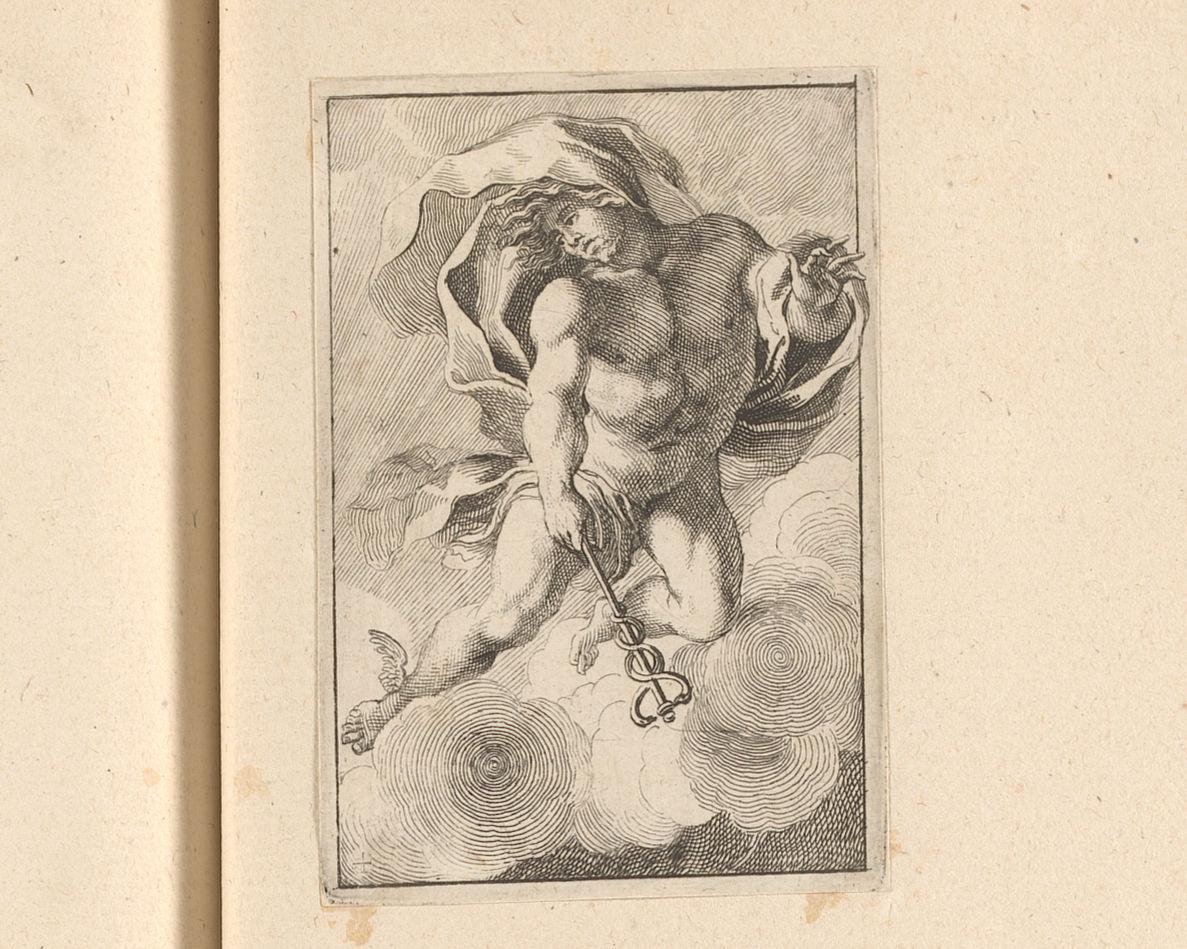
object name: album leaf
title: Mercurius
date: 1665-1673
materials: paper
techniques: etching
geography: paris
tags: model-books ~ implements of painter, (story of) mercury (hermes)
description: Maakt deel uit van een 32-delige serie met tekenvoorbeelden van goden en helden uit de klassieke oudheid. Een eerste editie werd in 1673 uitgegeven en een tweede in 1684 door Nicolas Langlois.